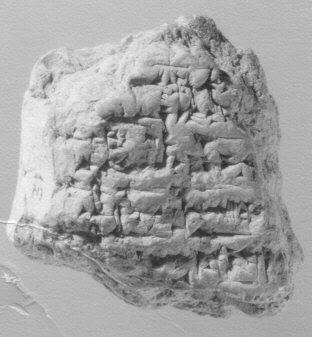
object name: cuneiform tablet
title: Cuneiform tablet: bilingual unidentified fragment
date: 333-1 BCE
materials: clay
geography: mesopotamia